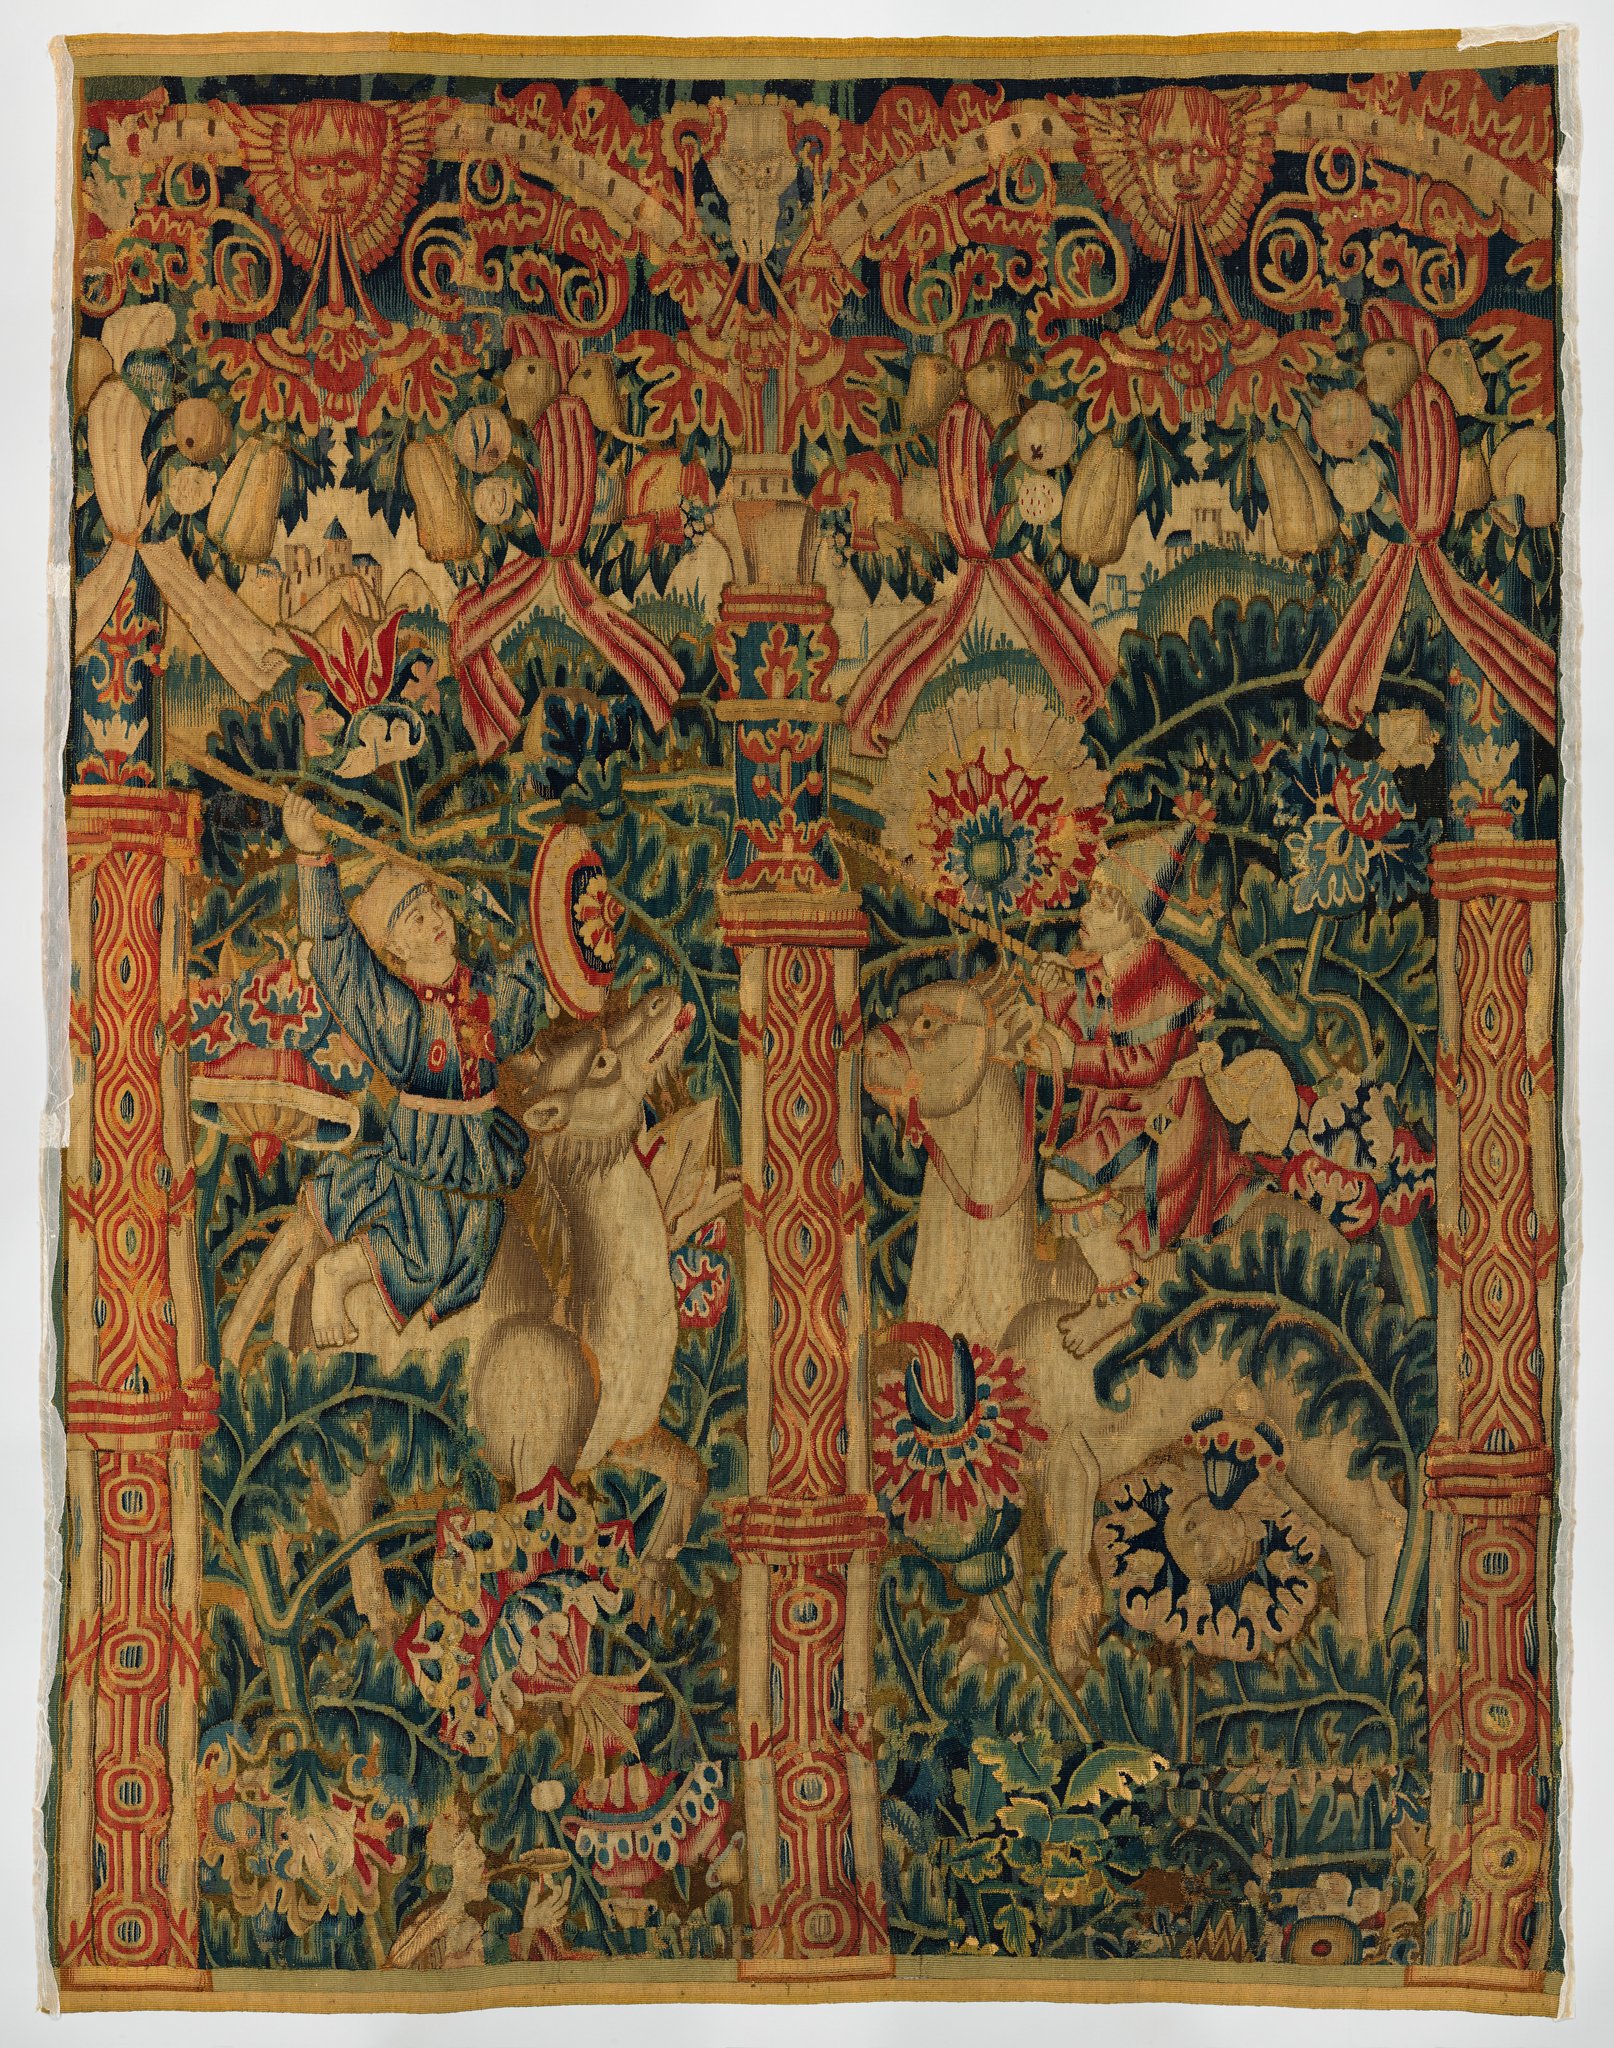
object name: tapestry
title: Arcades with Riders in Fantastic Thickets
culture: south netherlandish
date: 1520-1550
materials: silk, wool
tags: animals,men